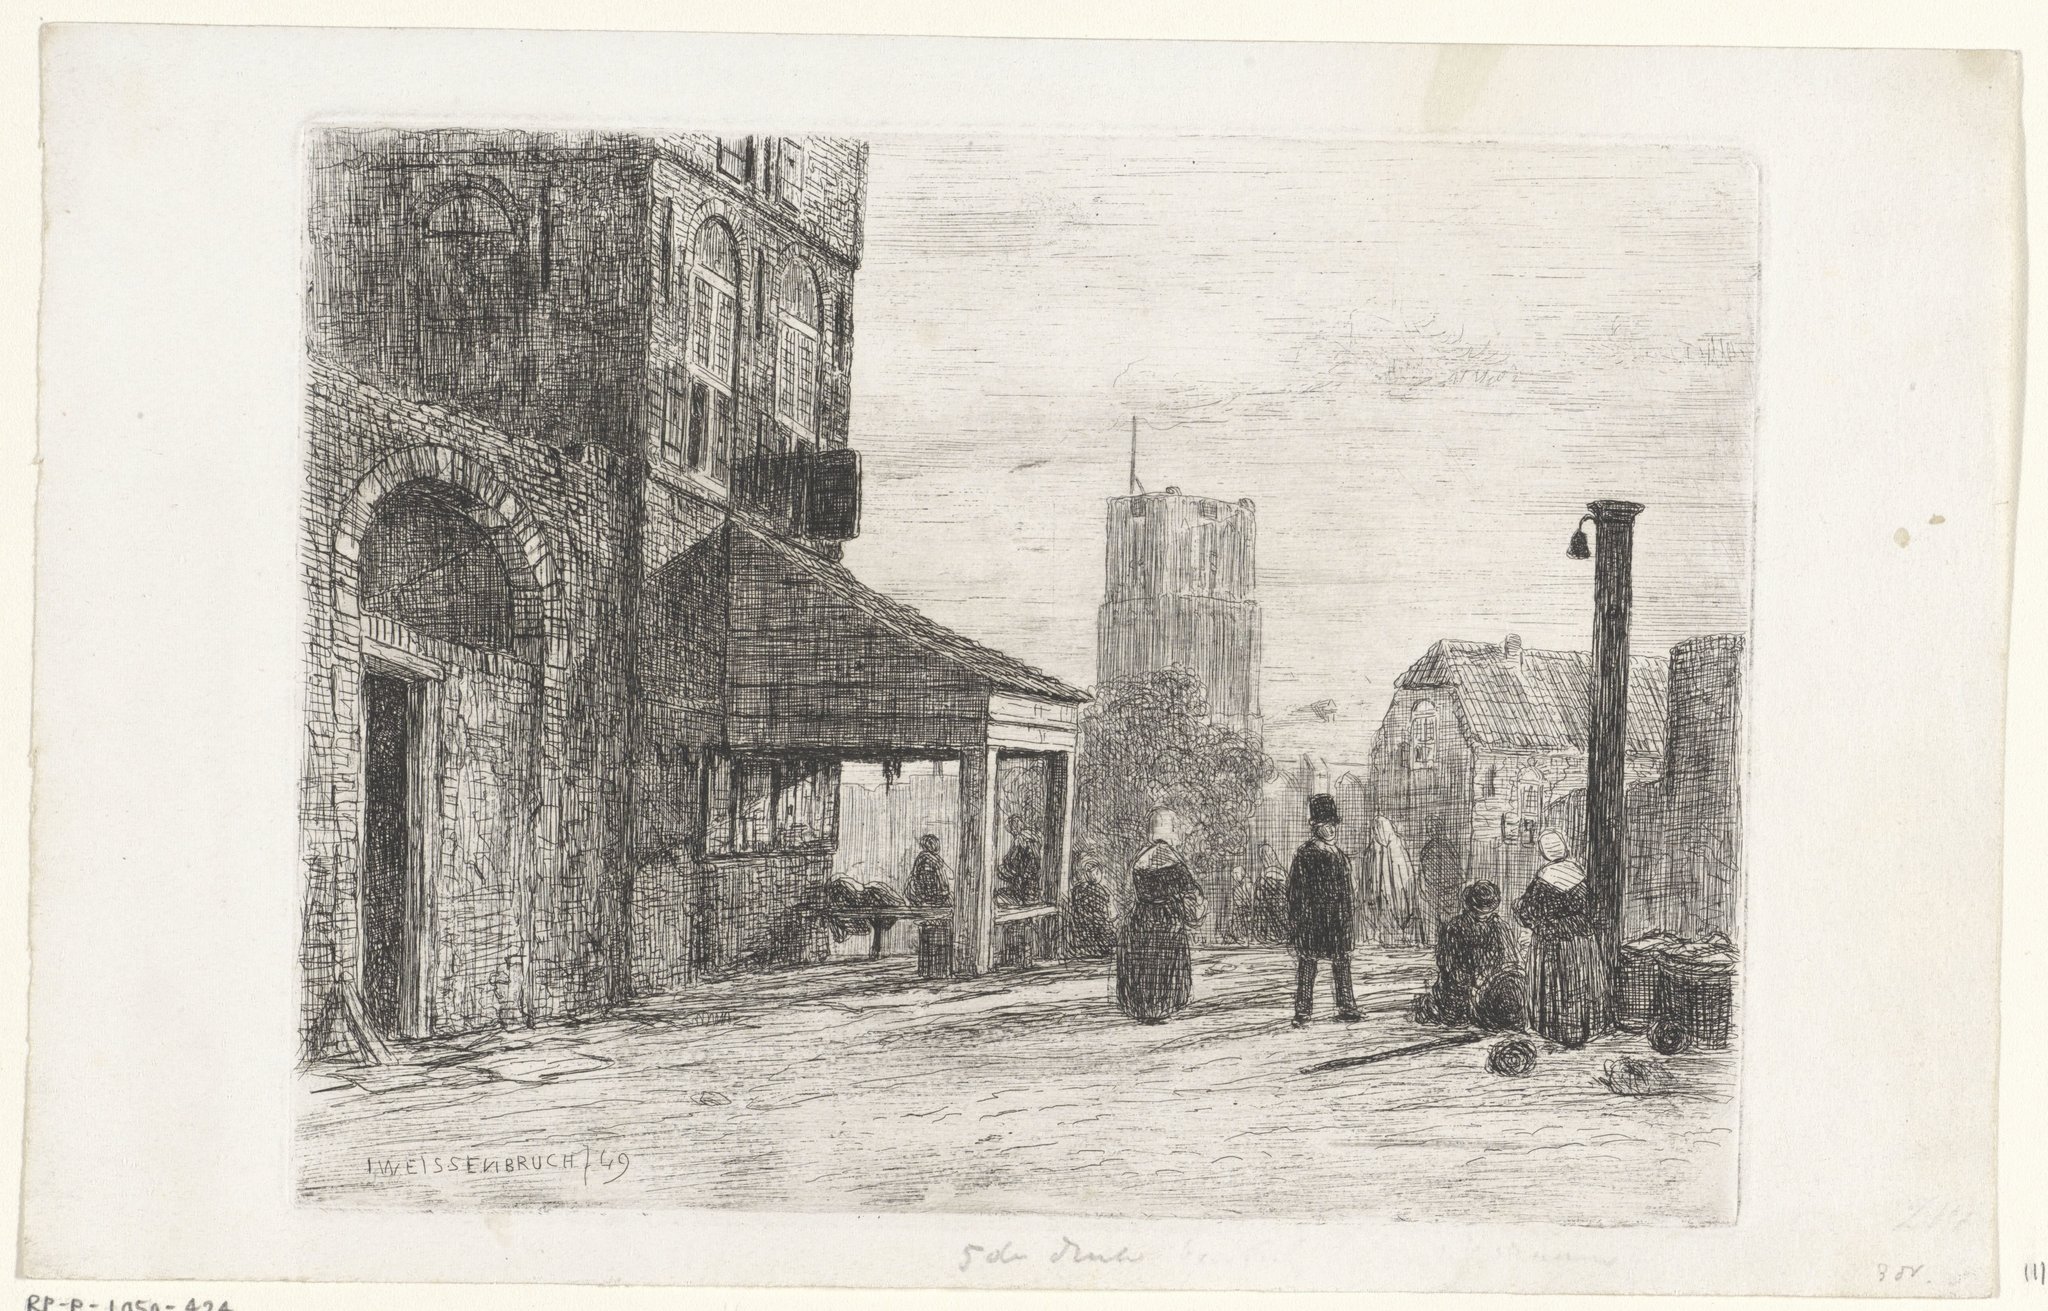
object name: print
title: Gezicht op de Sint-Martinuskerk te Woudrichem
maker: jan weissenbruch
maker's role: painter, print maker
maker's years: 1822-1880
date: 1849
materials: paper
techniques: etching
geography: the hague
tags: urban housing, adult woman, adult man, container made of plant material other than wood: basket, church (exterior), parts of church exterior and annexes, village square, place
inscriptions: date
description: Aan een dorpsplein staan enkele huizen. Rechts bevinden zich enkele figuren met manden rondom een paal met een lantaarn of een bel. In de verte is de Sint-Martinuskerk te zien.